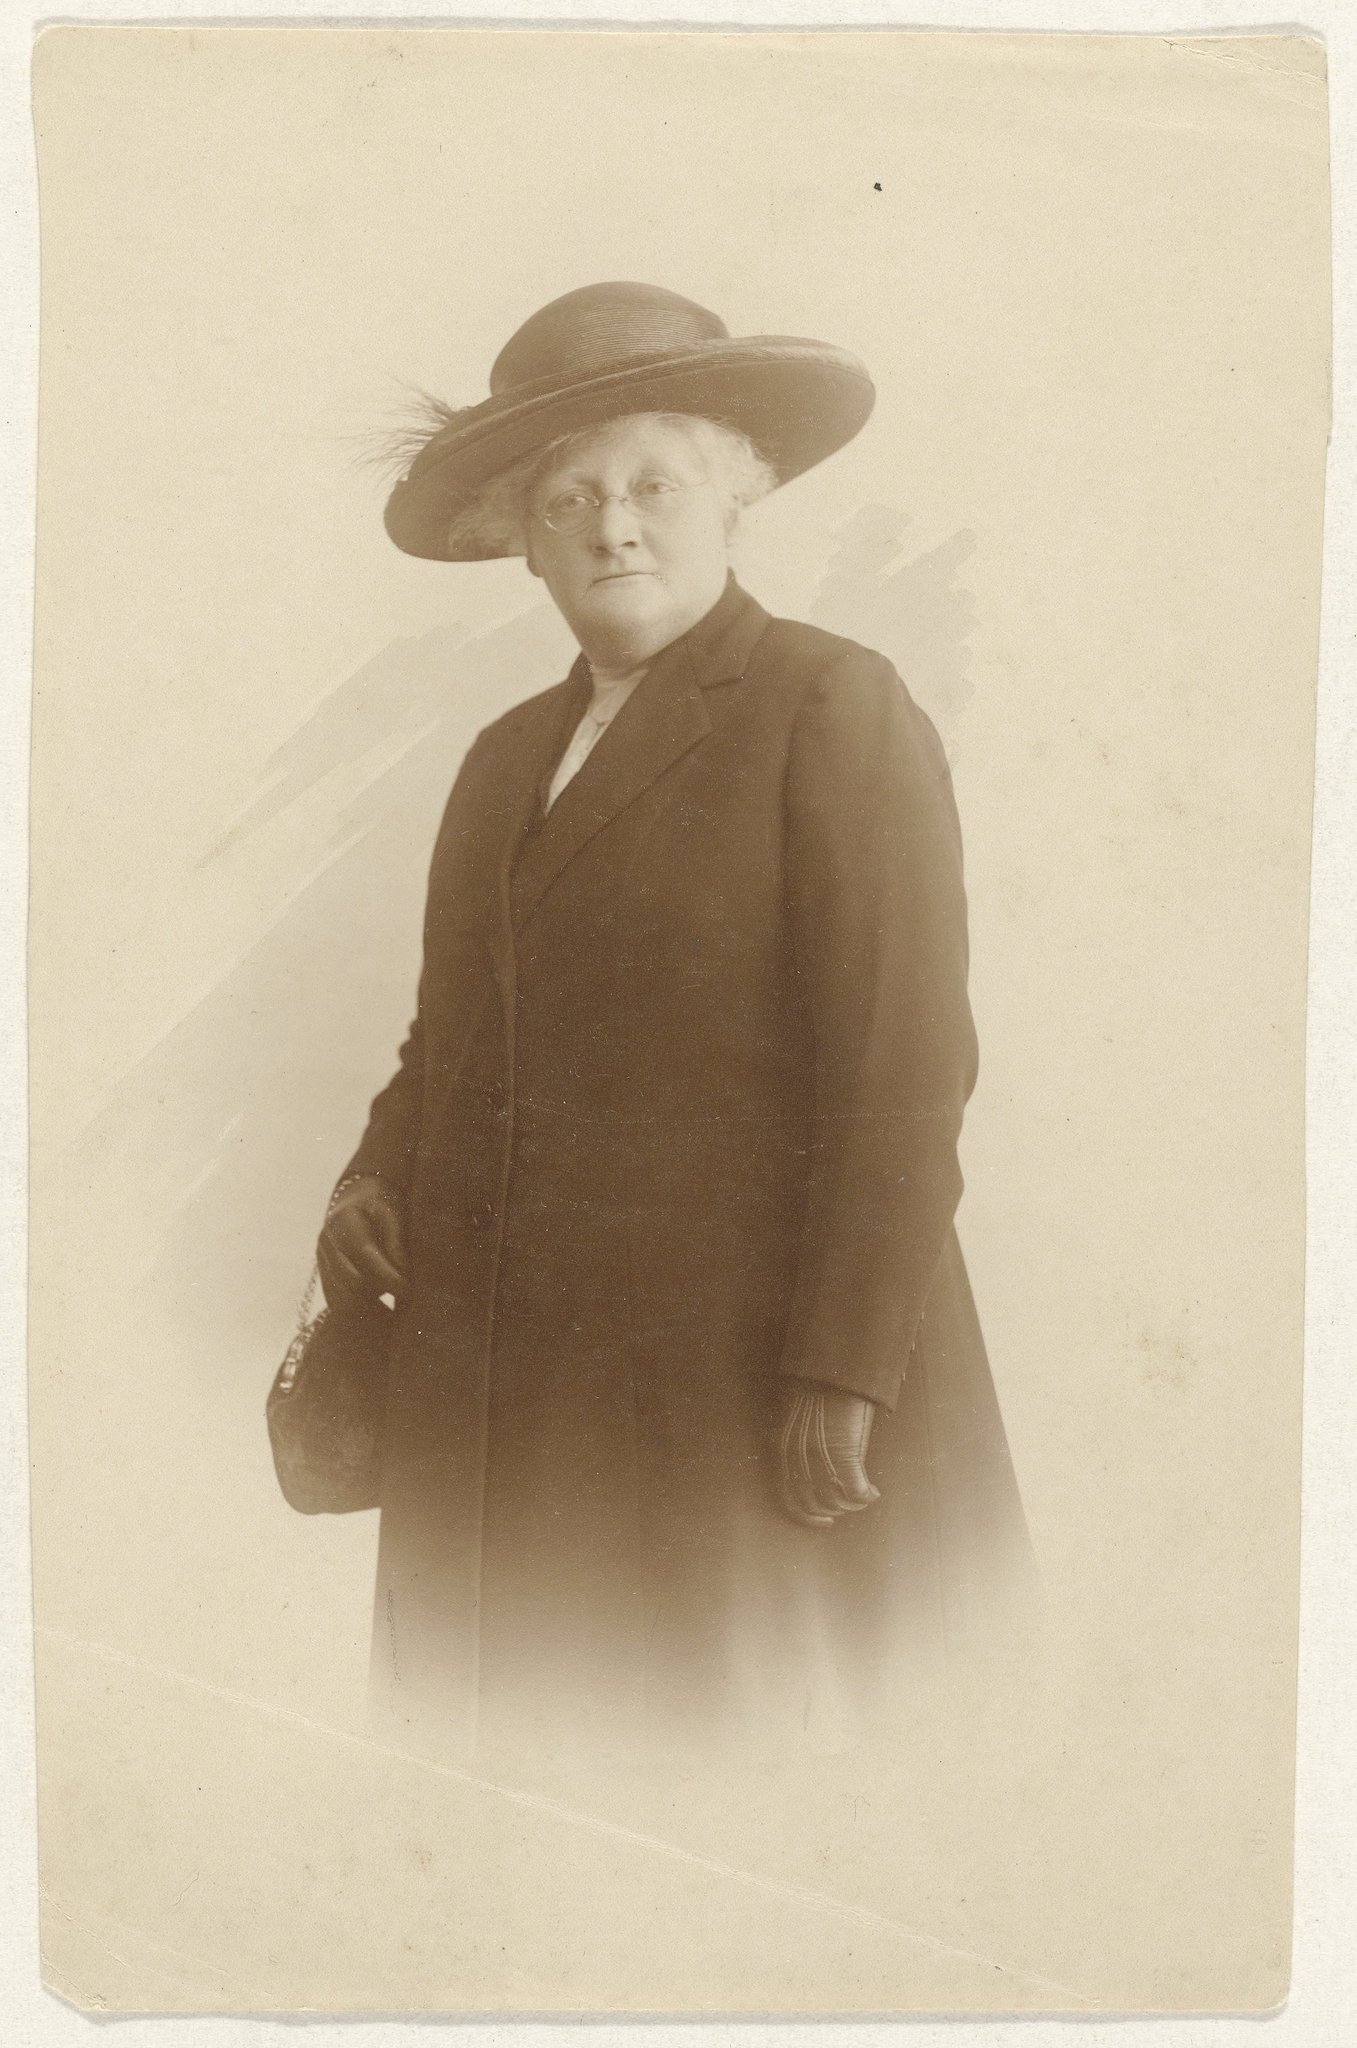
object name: photograph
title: Portret van Grietje Vermeulen op latere leeftijd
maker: Anonymous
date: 1910-1940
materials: photographic support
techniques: gelatin silver print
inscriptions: inscription: ‘Grietje’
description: Grietje Vermeulen in lange winterjas met hoed en handschoenen.